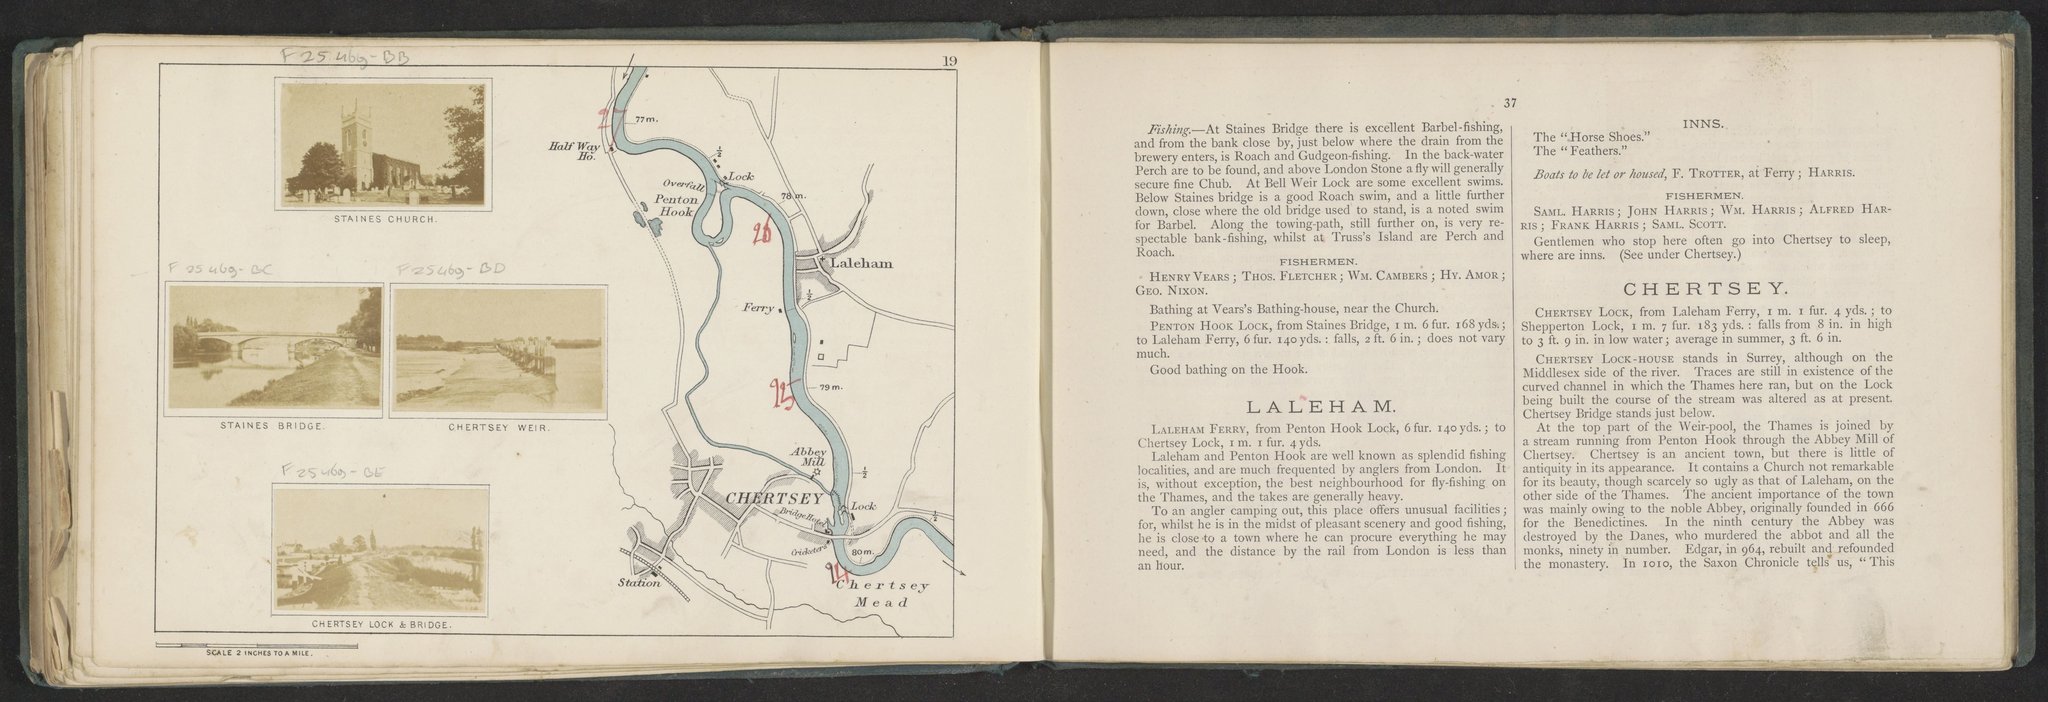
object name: page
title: Chertsey lock and bridge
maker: henry w. taunt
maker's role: fotograaf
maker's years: 1842-1922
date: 1871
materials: photographic support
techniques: albumen print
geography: chertsey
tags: sluice, weir, river, bridge, thames